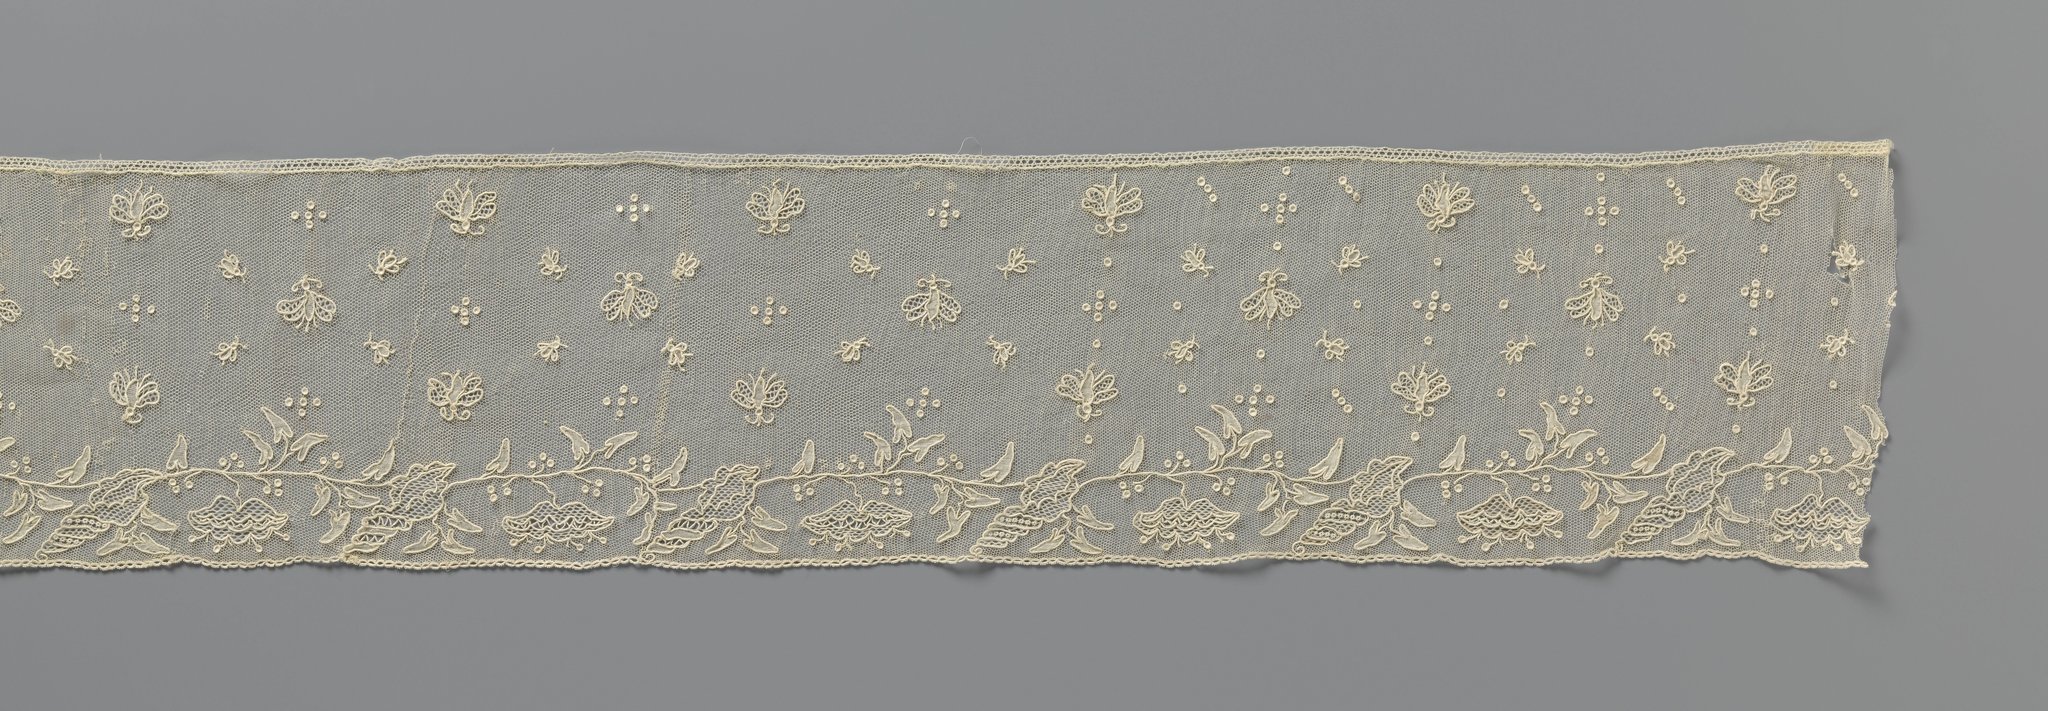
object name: strip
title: Strook naaldkant met gevleugde insecten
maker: Anonymous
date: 1805-1810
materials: linen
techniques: lace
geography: france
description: Strook naturelkleurige naaldkant: Alençon-kant. Strooimotief met een welbepaald symmetrisch patroon van grotere en kleinere gevleugde insecten en vijfvoudige moesjes. Het strooimotief staat op een fijne zeshoekige maasgrond. Het patroon aan de onderzijde van de strook bestaat uit een doorlopende rozentak waarover steeds een hoornschelp ligt. Verschillende siergronden in de vleugels van de insecten, de rozenbladeren en de schelpen. De onderzijde is afgewerkt met een rechte rand van gefestonneerde picots. De bovenzijde is afgezet met een rand kloskant.